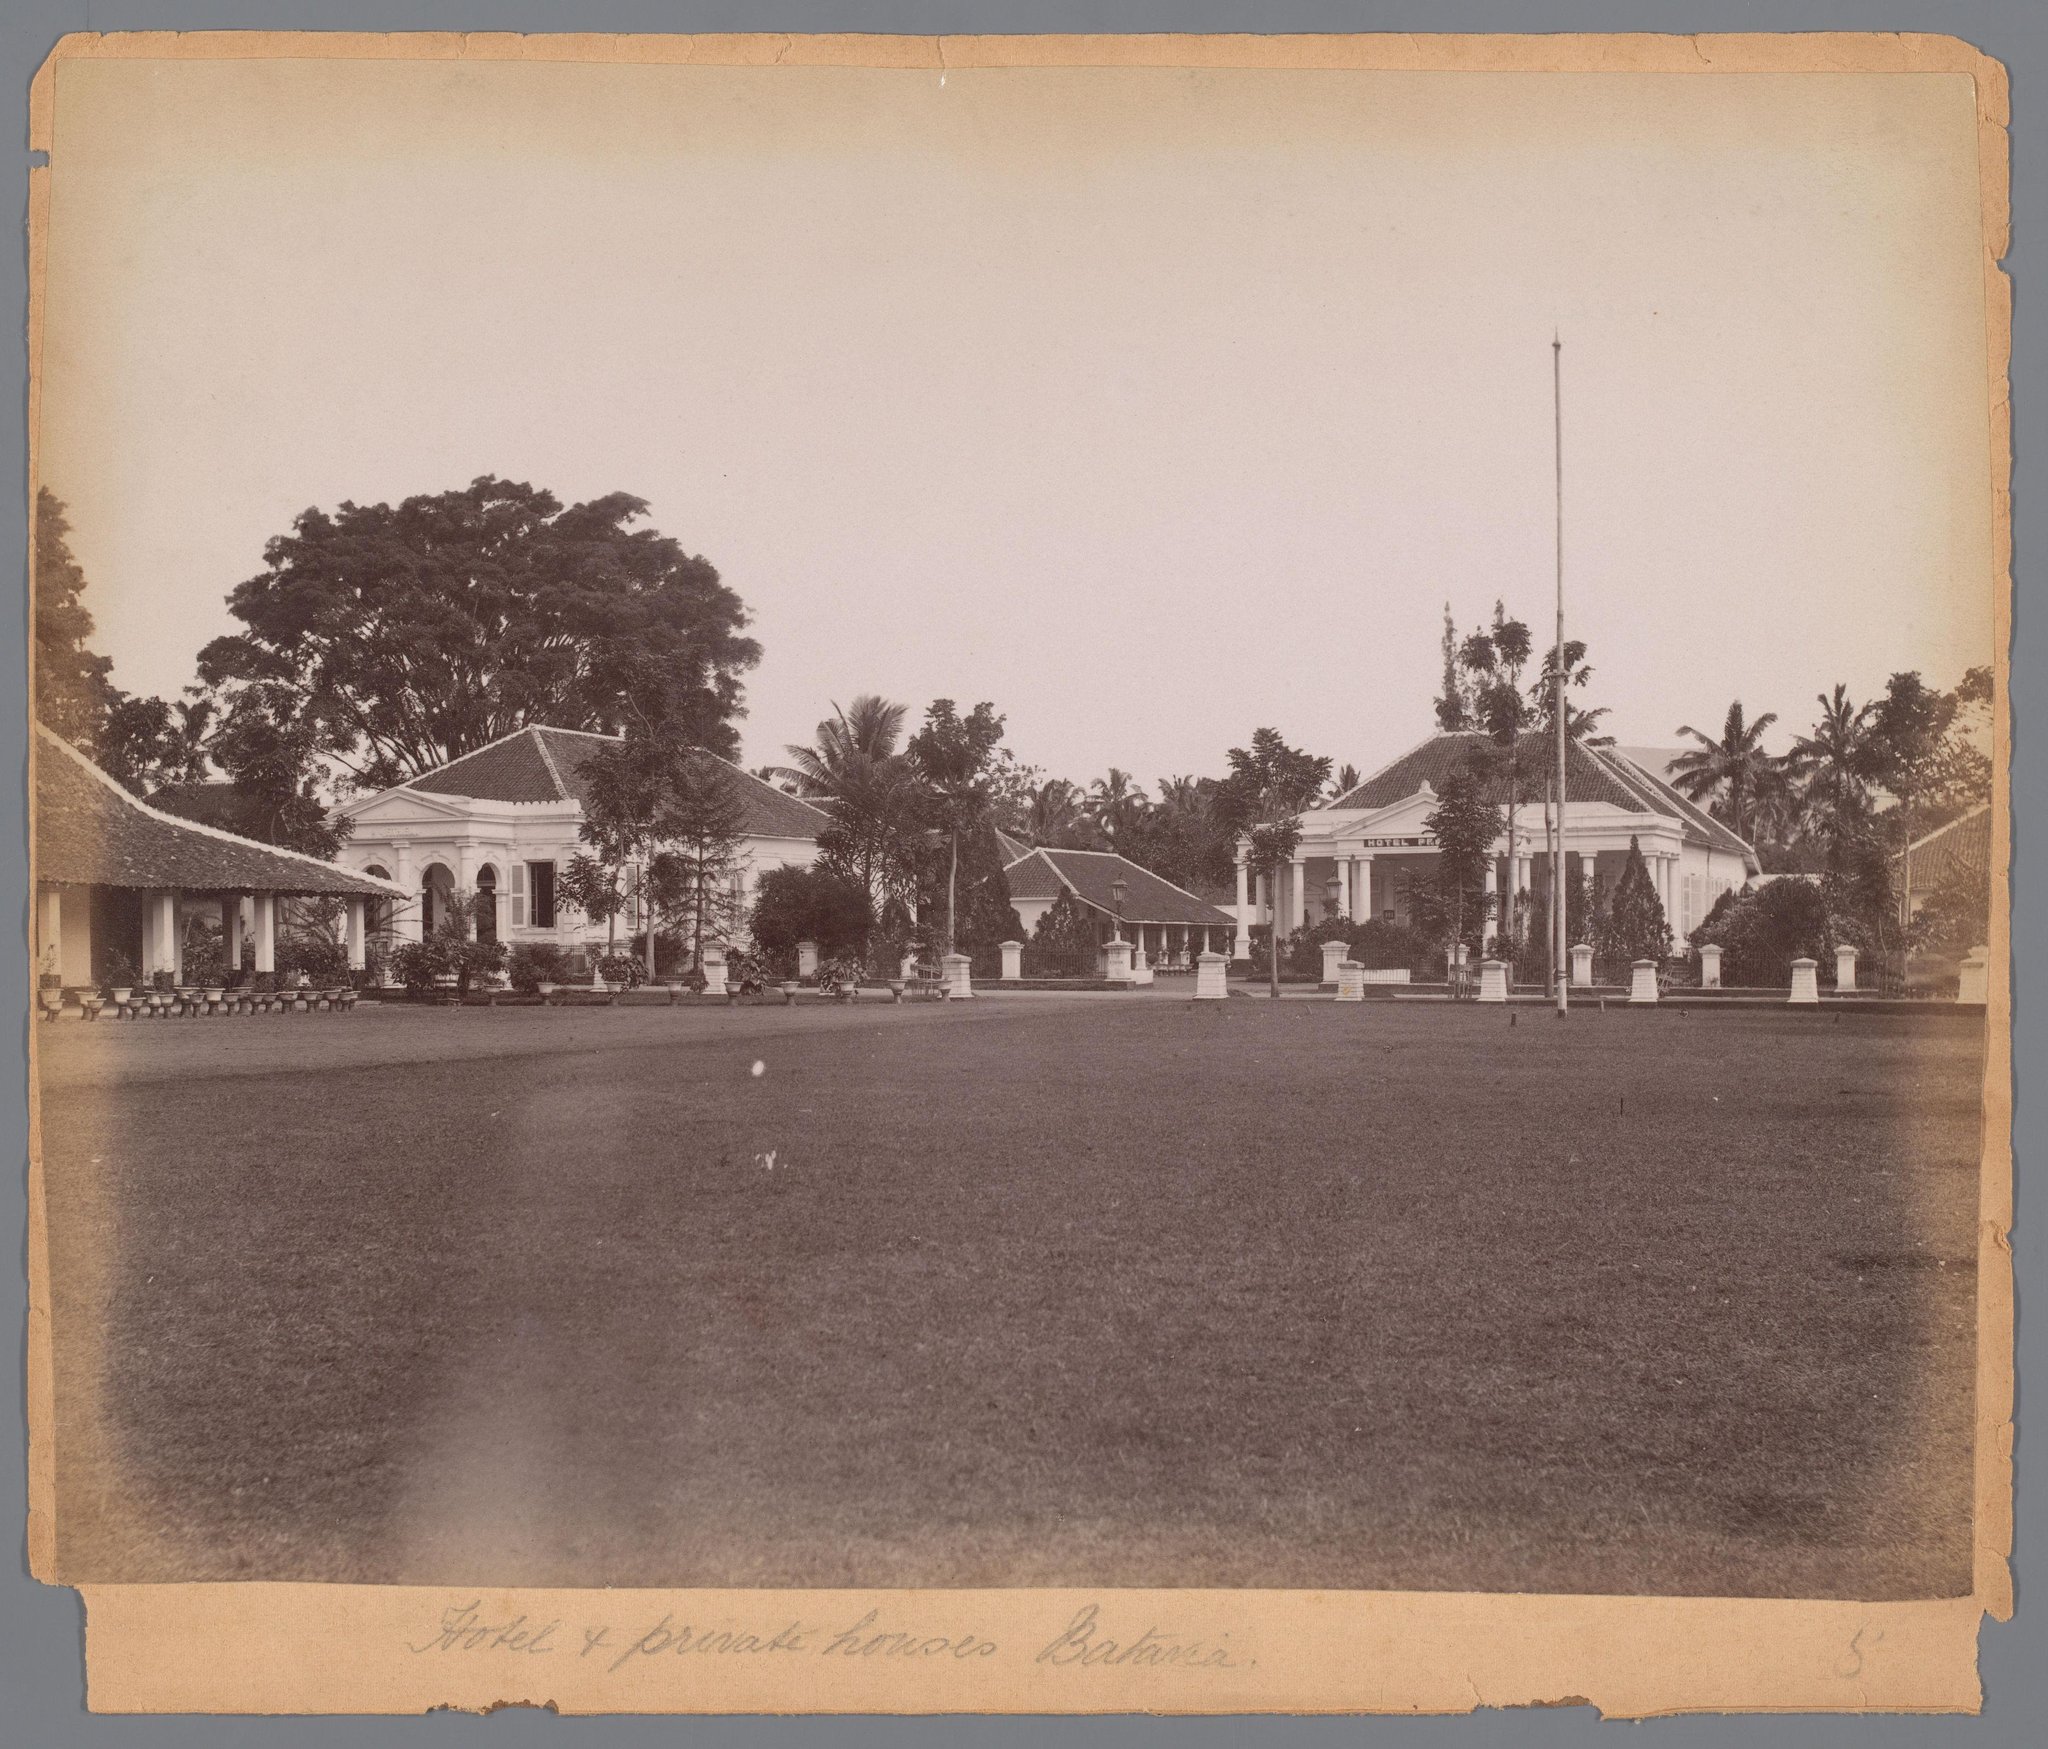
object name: photograph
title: Hotel en privé-woonhuizen in Batavia (huidige Jakarta)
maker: Anonymous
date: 1900-1915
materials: cardboard, paper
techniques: gelatin silver print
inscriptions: inscription: ‘Hotel + private houses Batavia.’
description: Hotel en privé-woonhuizen in Batavia (huidige Jakarta). Op de voorgrond een groot grasveld, een vlaggestik, en meerdere luxe wn grote huizen, met palmbomen ertussen. Mogelijk een albumblad.